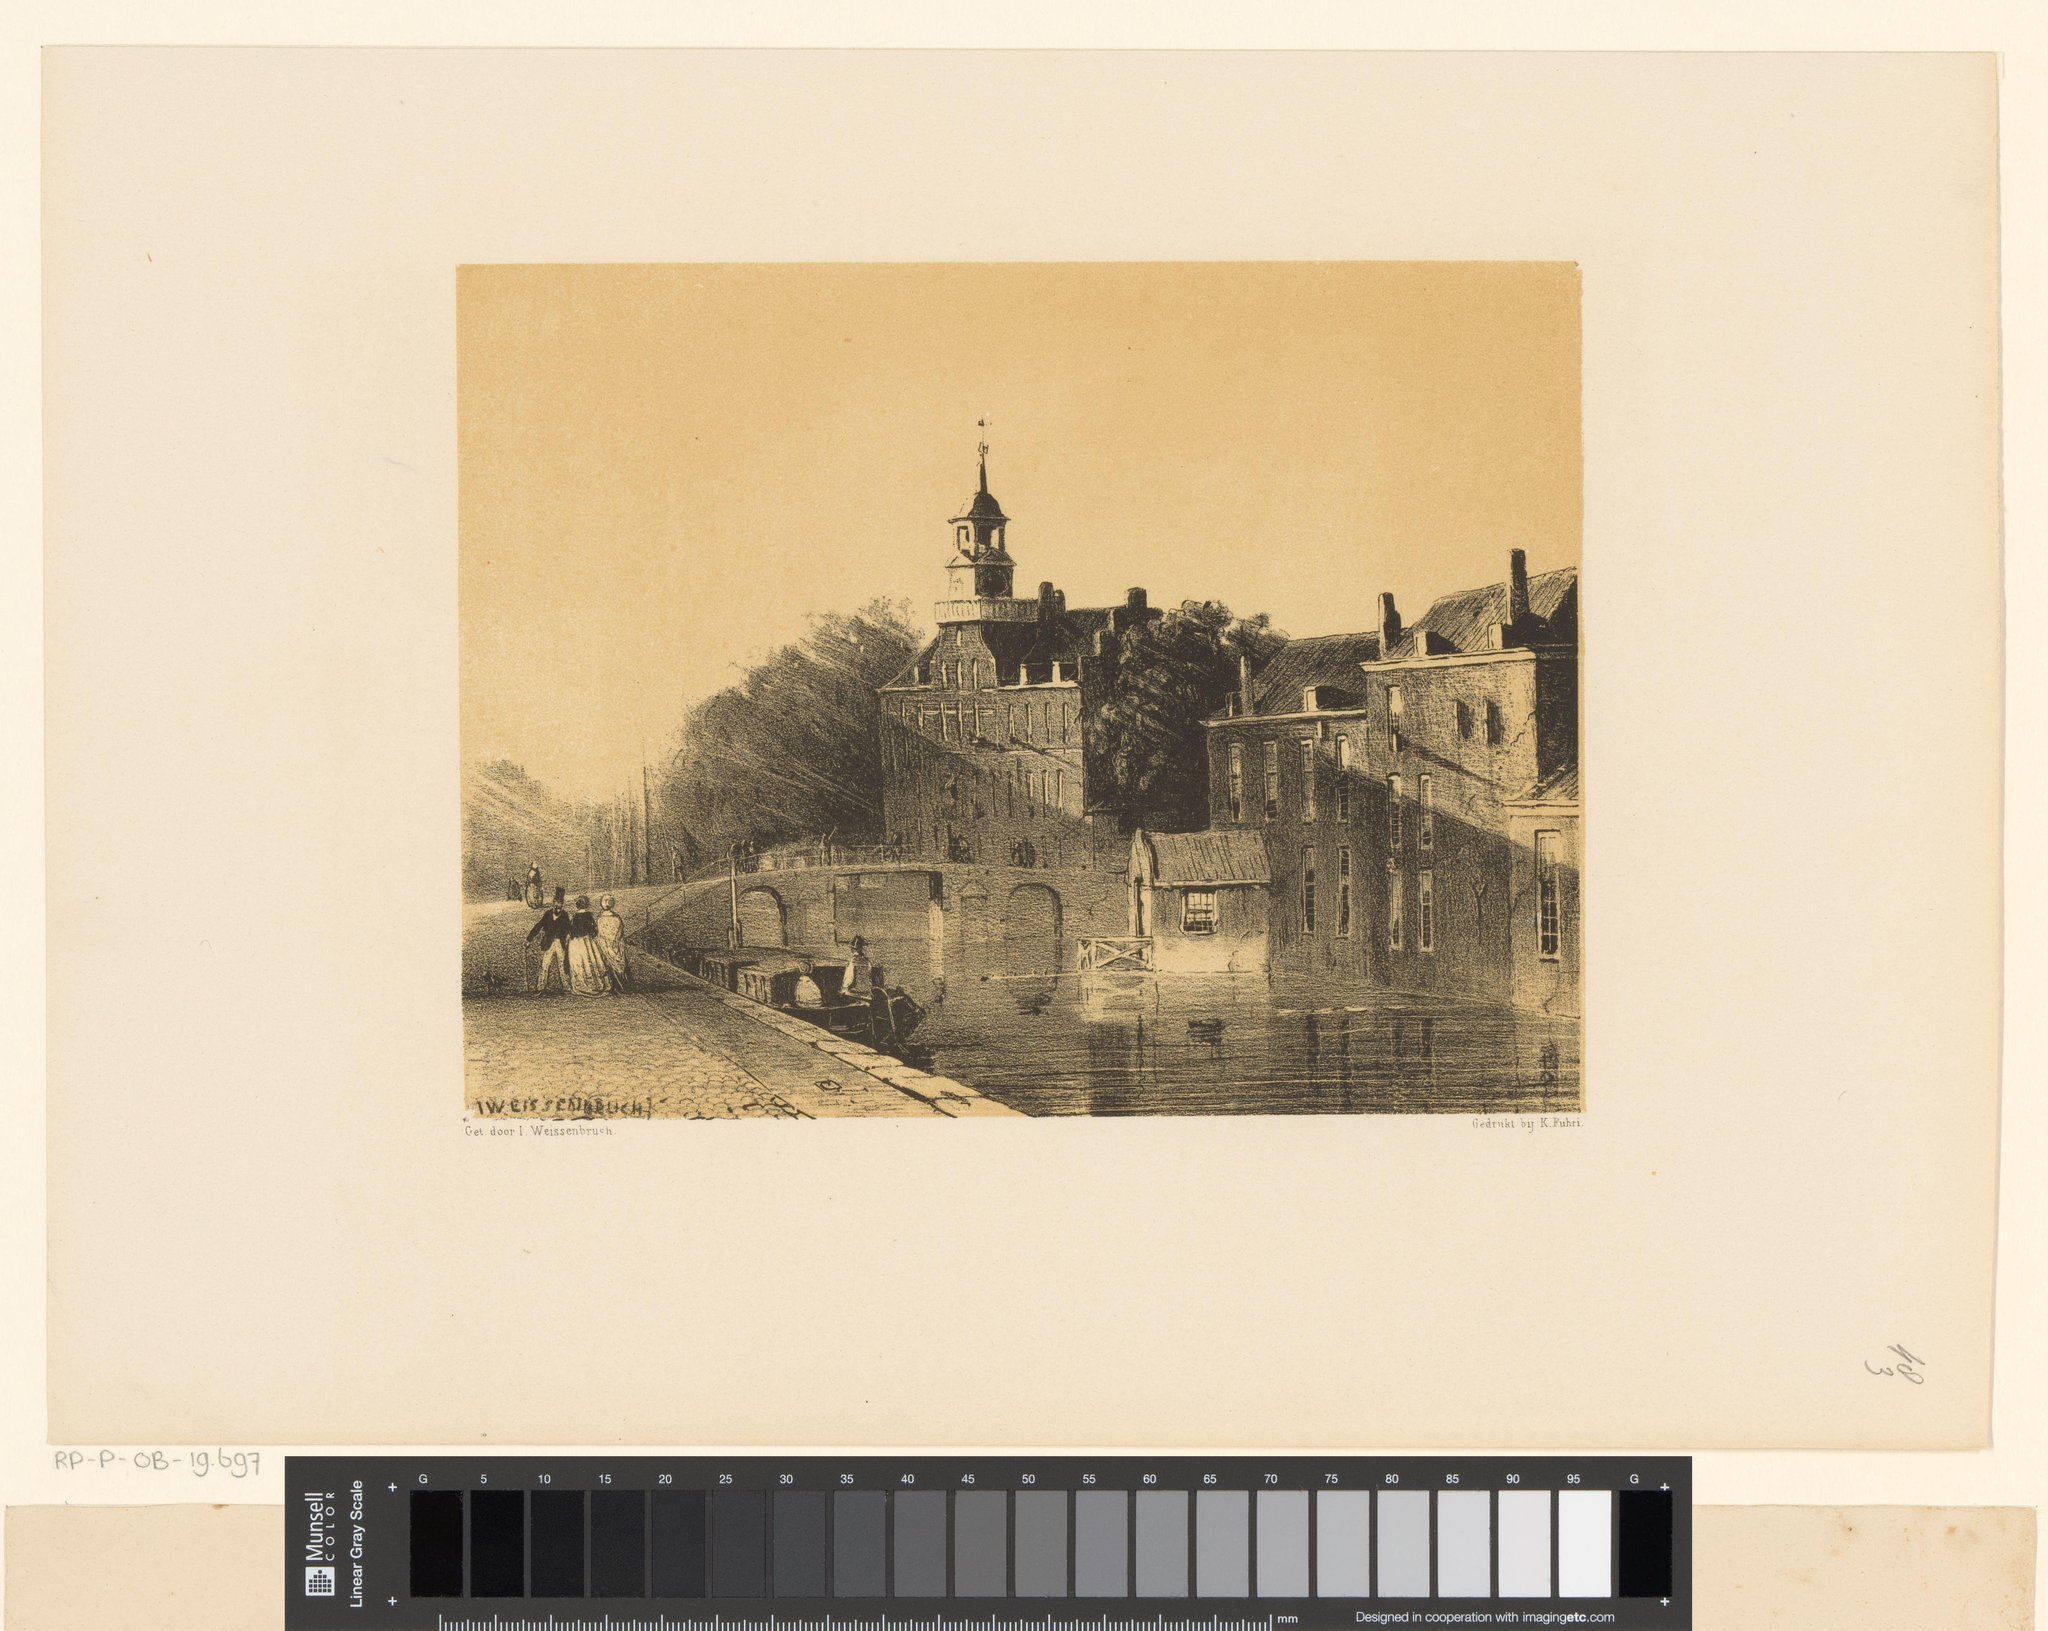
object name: print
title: Stadsgezicht met gracht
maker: koenraad fuhri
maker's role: bookseller, printer, publisher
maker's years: 1814-1858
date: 1837-1855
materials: paper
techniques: tone lithography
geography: the hague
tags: city-view in general; 'veduta', canal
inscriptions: collector's mark: Lugt 2228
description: Gezicht op een stad met een gracht waarover een brug loopt. Rechts liggen huizen en een gebouw met toren.